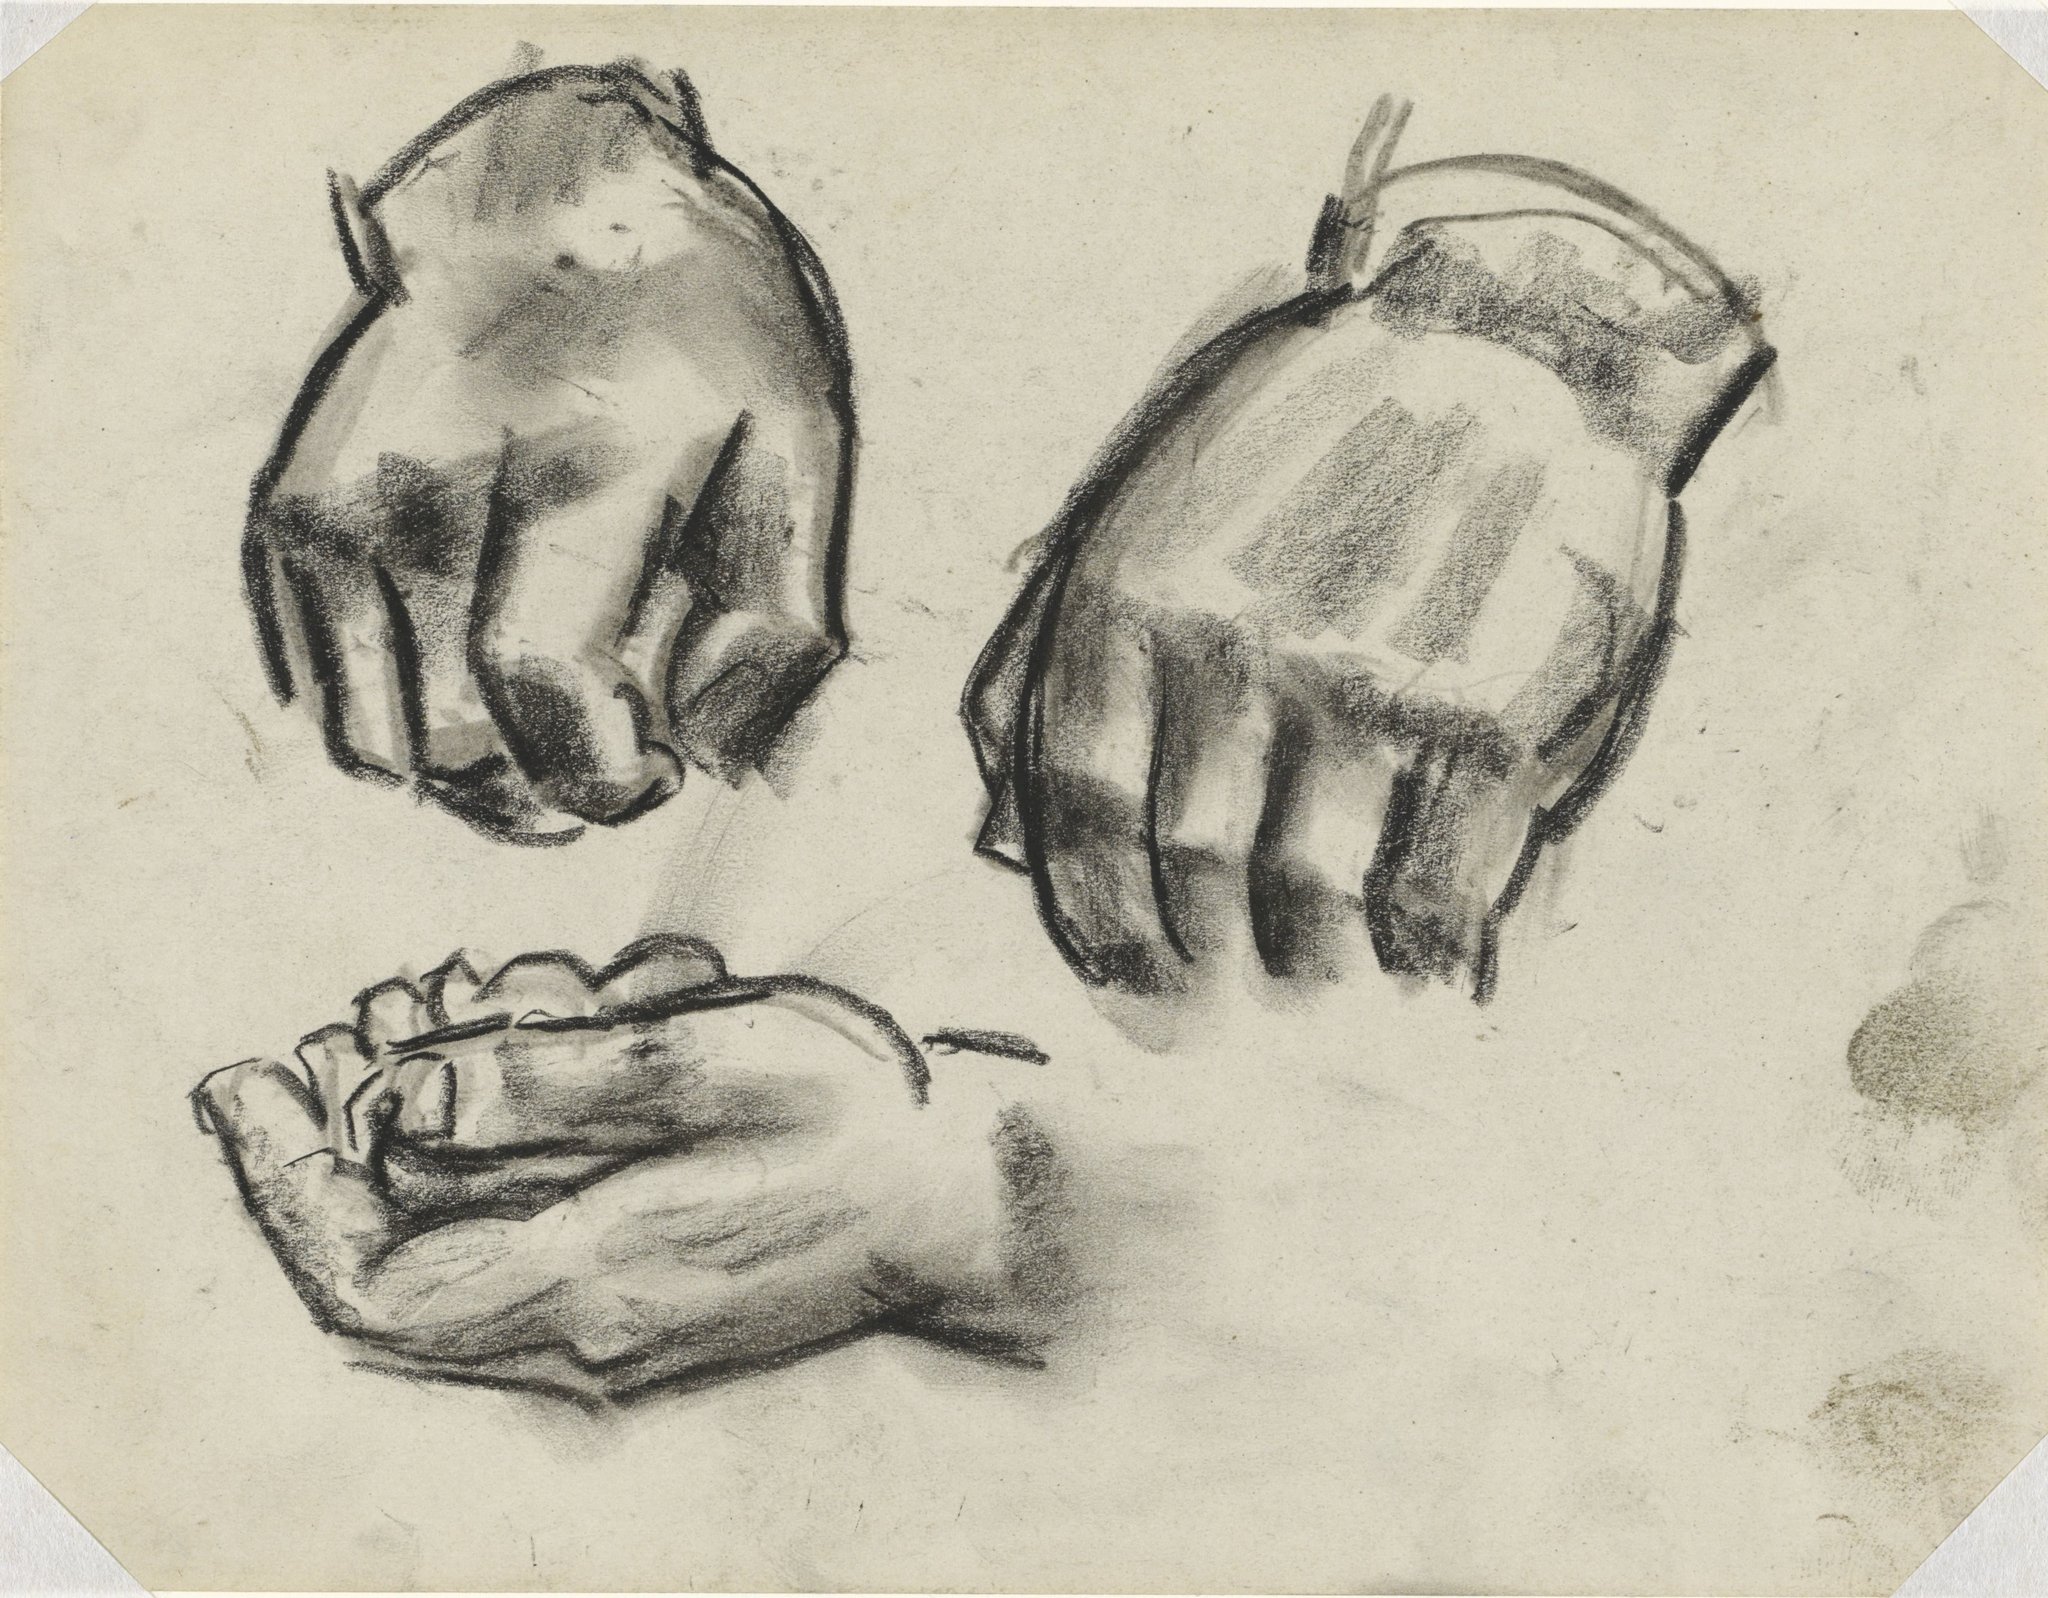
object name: drawing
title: Zonder titel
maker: leo gestel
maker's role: draughtsman, print maker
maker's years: 1881-1941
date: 1925-1927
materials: chalk, charcoal, paper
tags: hand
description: Blad met drie studies van handen, de twee bovenste op de rug gezien, de onderste van opzij gezien